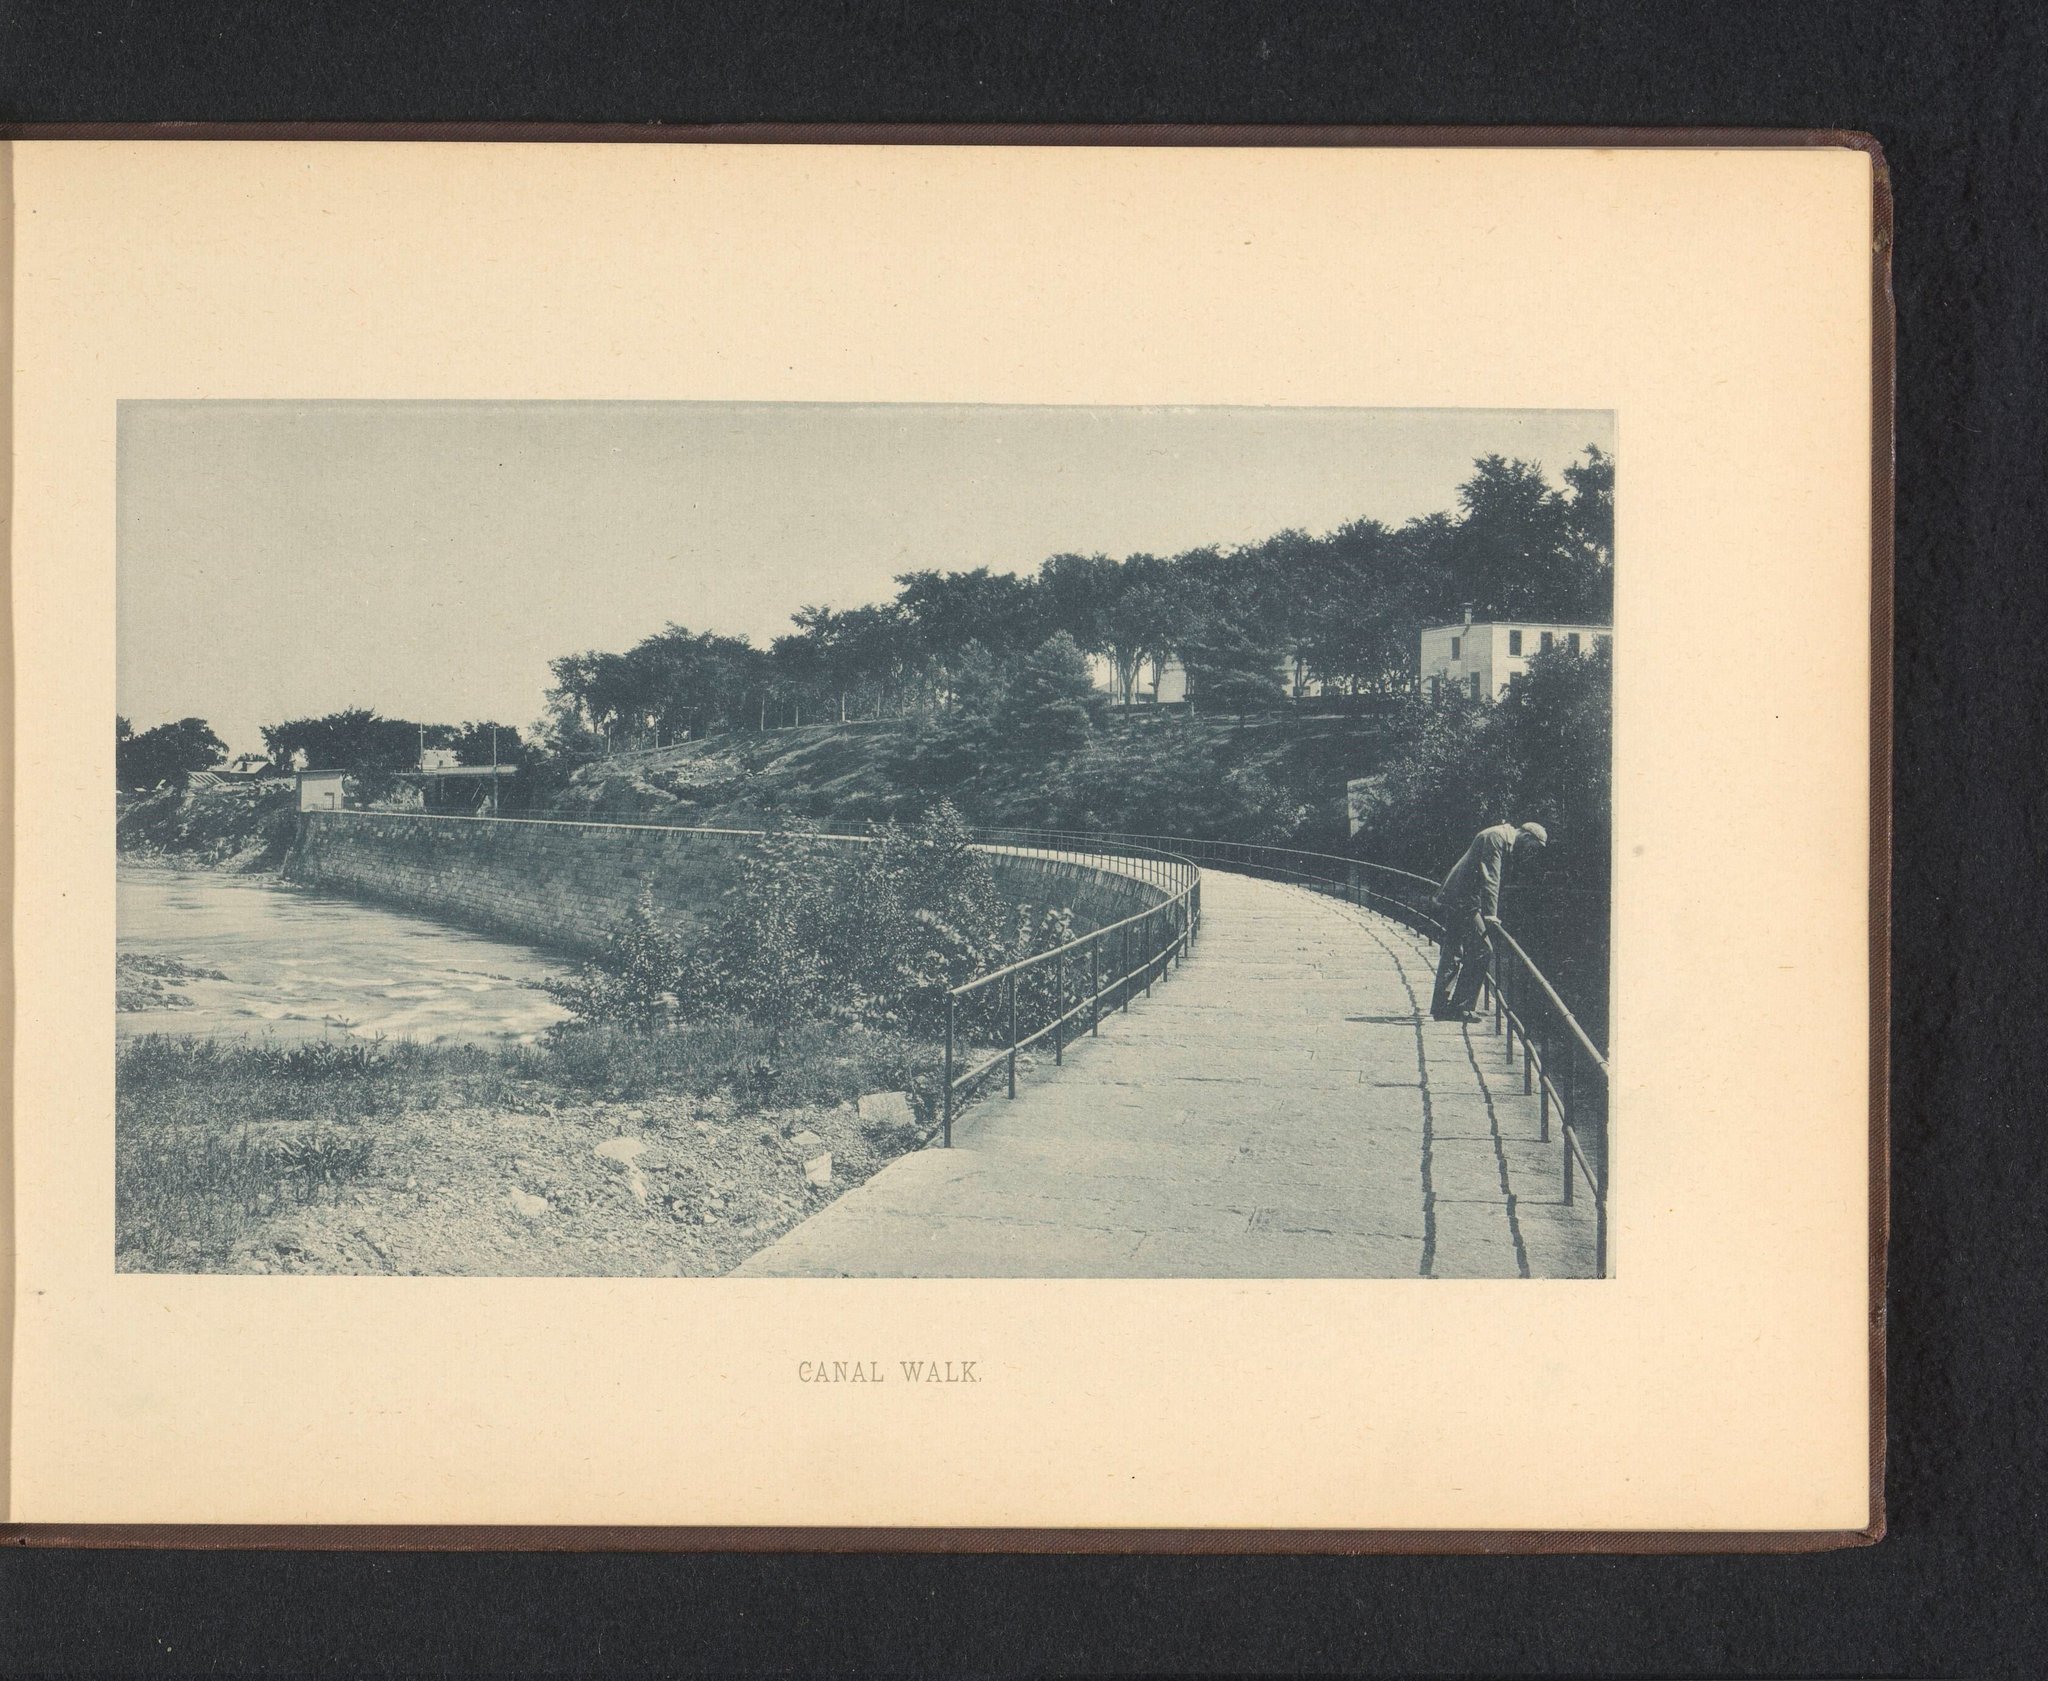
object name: photomechanical print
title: Gezicht op een man bij het Pawtucket kanaal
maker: Anonymous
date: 1887-1892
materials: paper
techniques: photograph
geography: lowell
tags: city-view in general; 'veduta', historical persons, canal